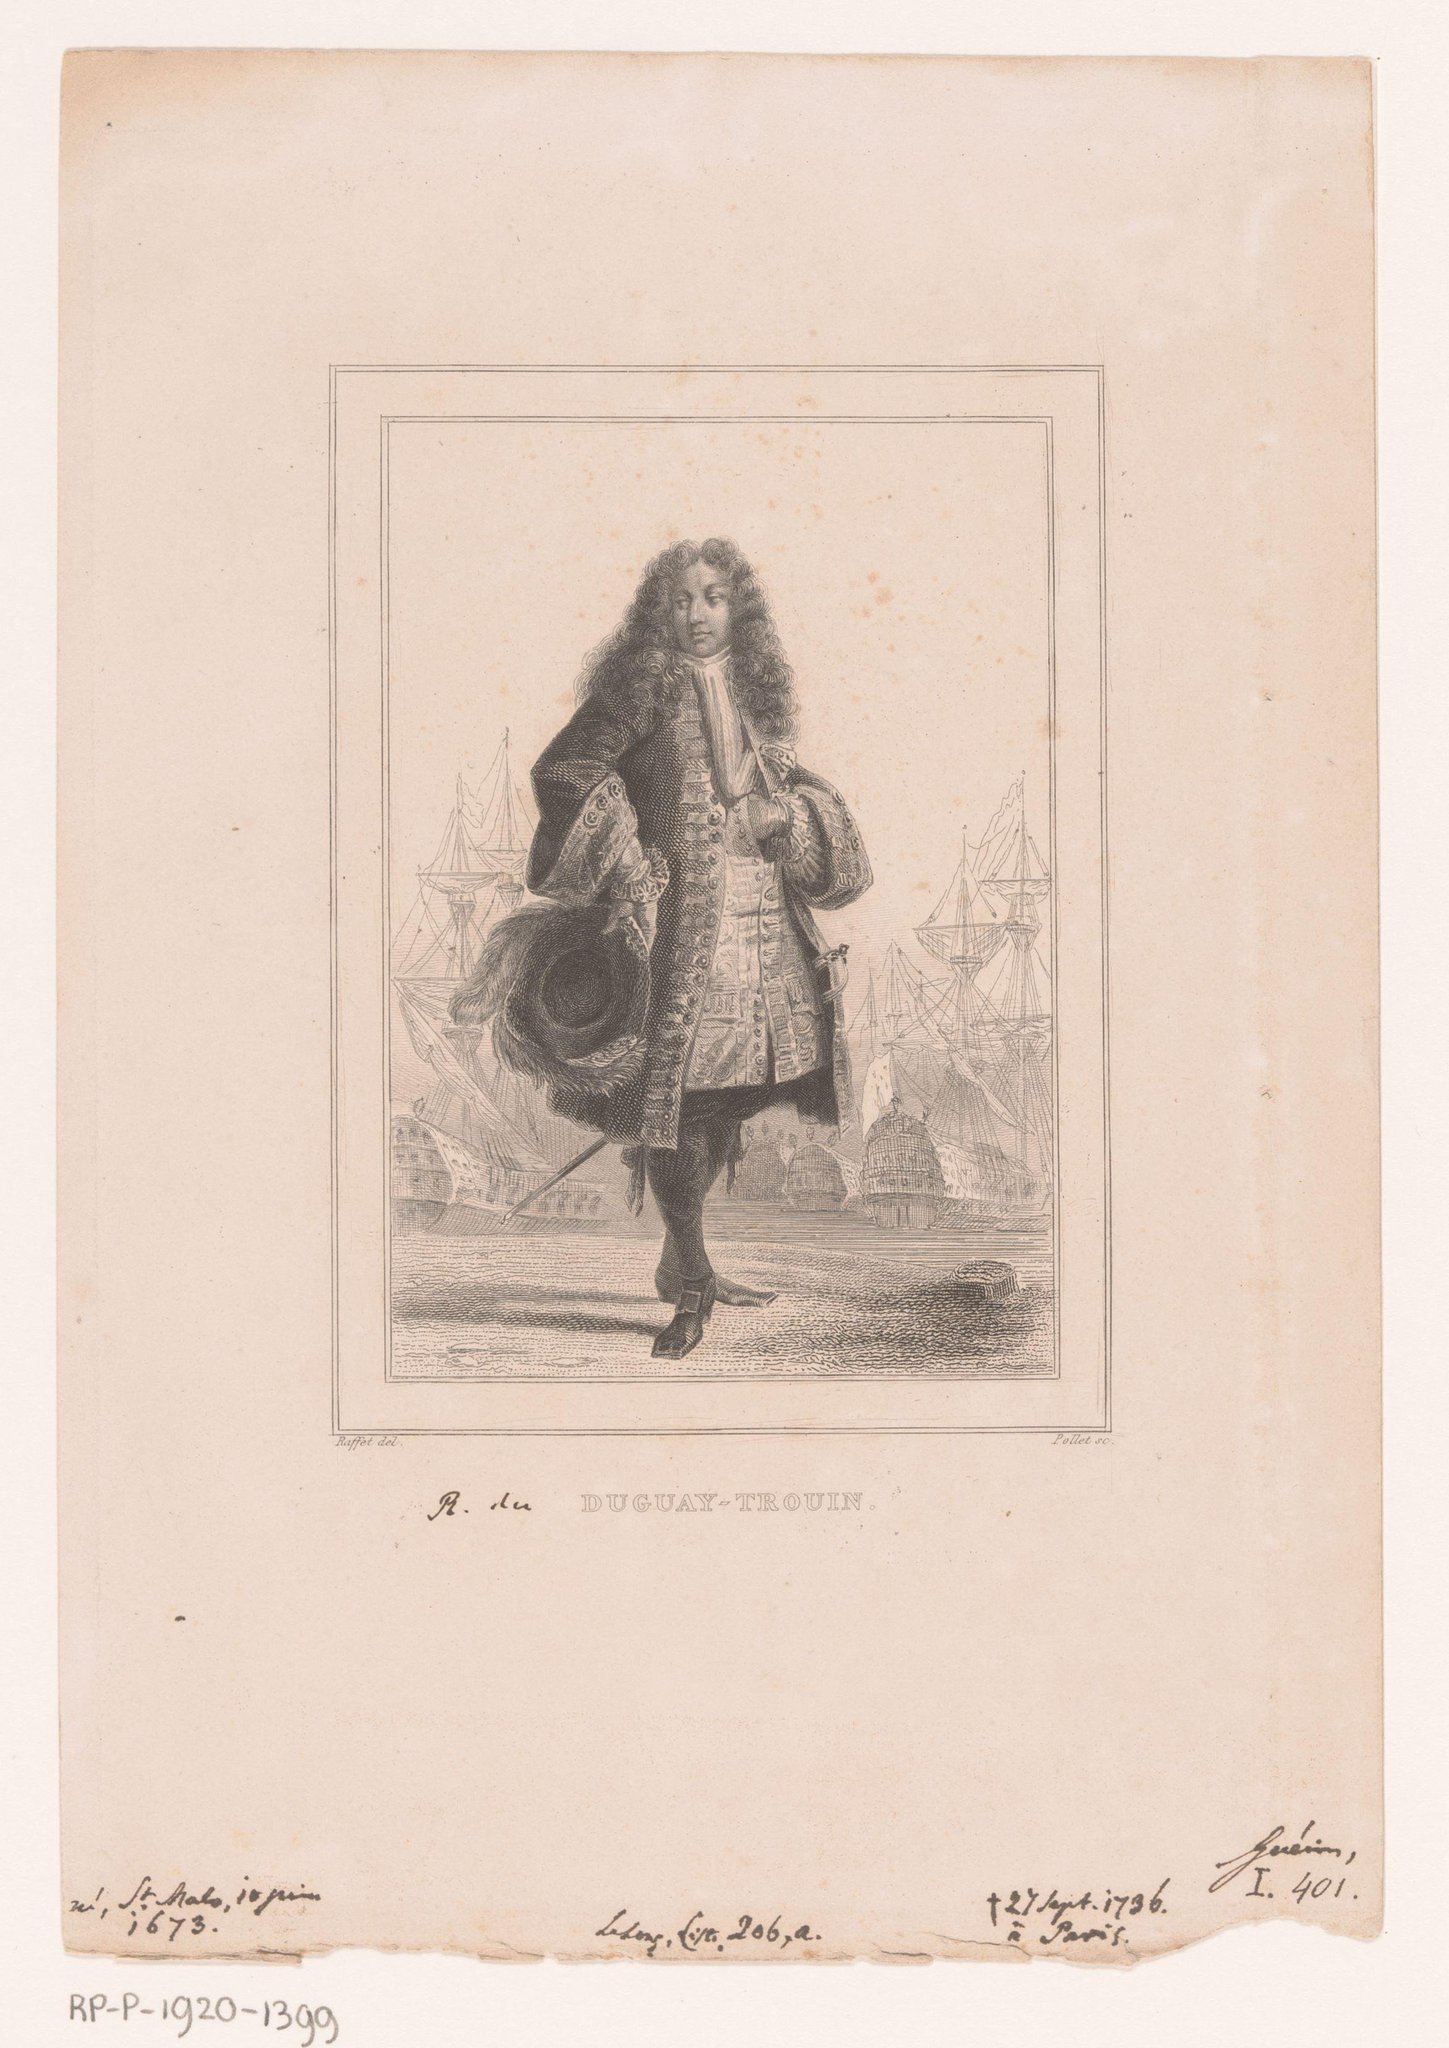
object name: book illustration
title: Portret van René Duguay-Trouin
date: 1835-1837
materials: paper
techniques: etching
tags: paris, capuche, pirate, corsair, buccaneer, historical persons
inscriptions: collector's mark: Lugt 2228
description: Prent uit: Sue, Eugène. Histoire de la marine française. Parijs: Félix Bonnaire, 1835-1837, 5 delen.